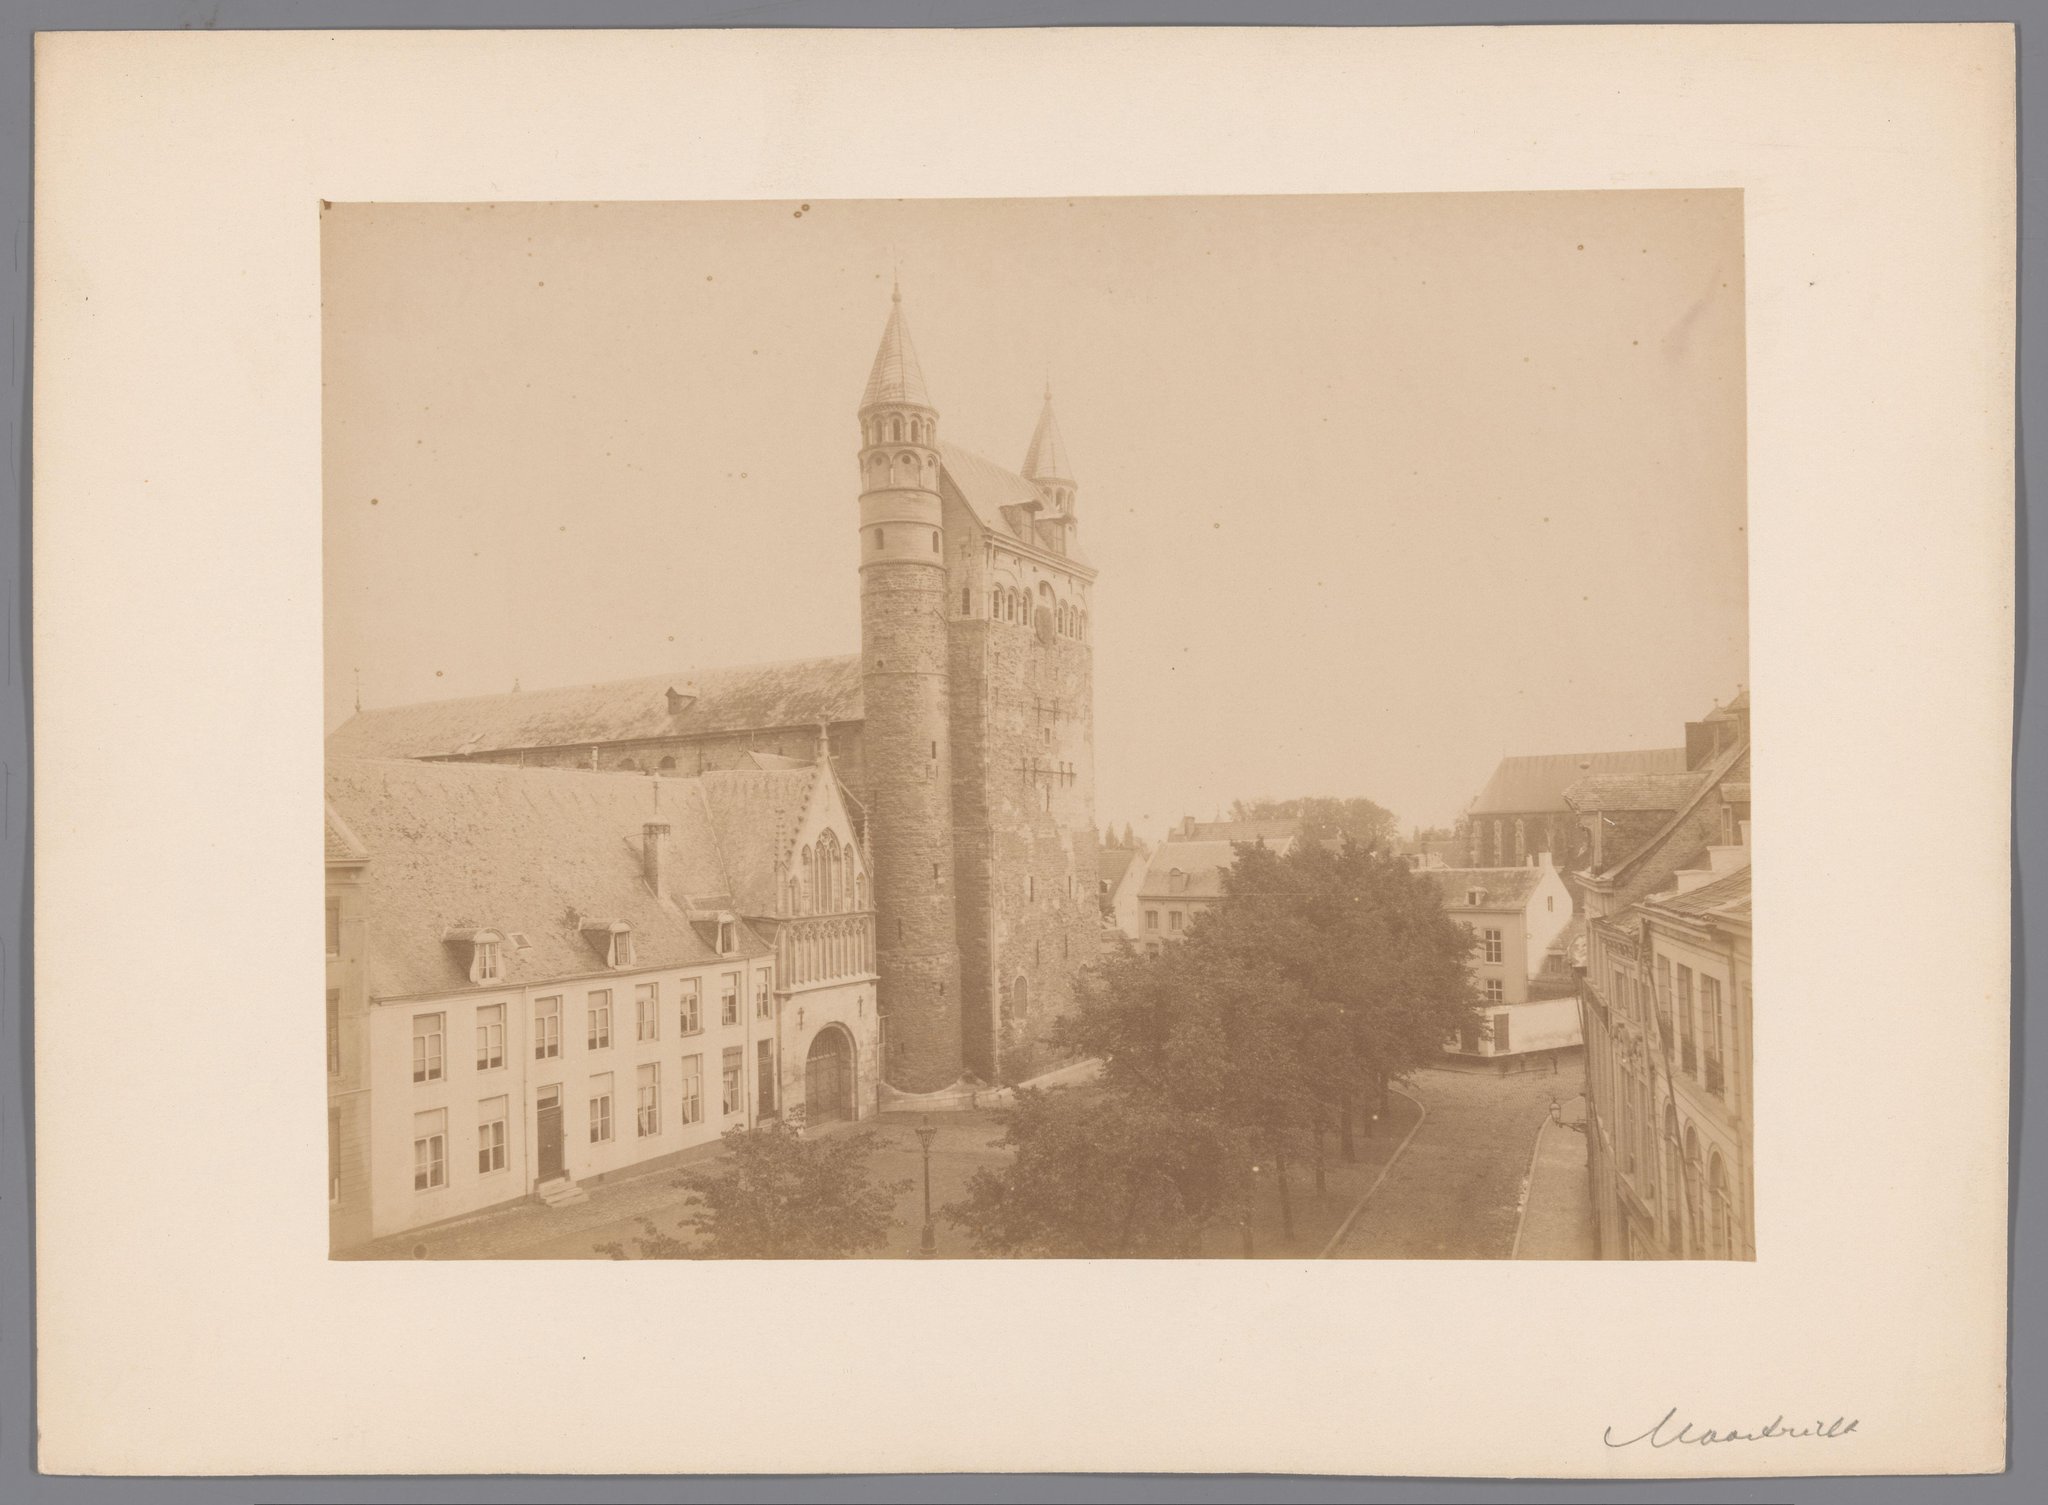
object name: photograph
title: Gezicht op het Onze Lieve Vrouweplein te Maastricht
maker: anoniem (monumentenzorg)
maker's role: fotograaf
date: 1893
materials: cardboard, photographic support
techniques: albumen print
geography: maastricht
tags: square, place, circus, etc. (+ city(-scape) with figures, staffage), parts of church exterior and annexes: tower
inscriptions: annotation: ‘Maastricht’, annotation: ‘Maastricht (L.)/ O.L.V. kerk westgevel/ Mei 1893’